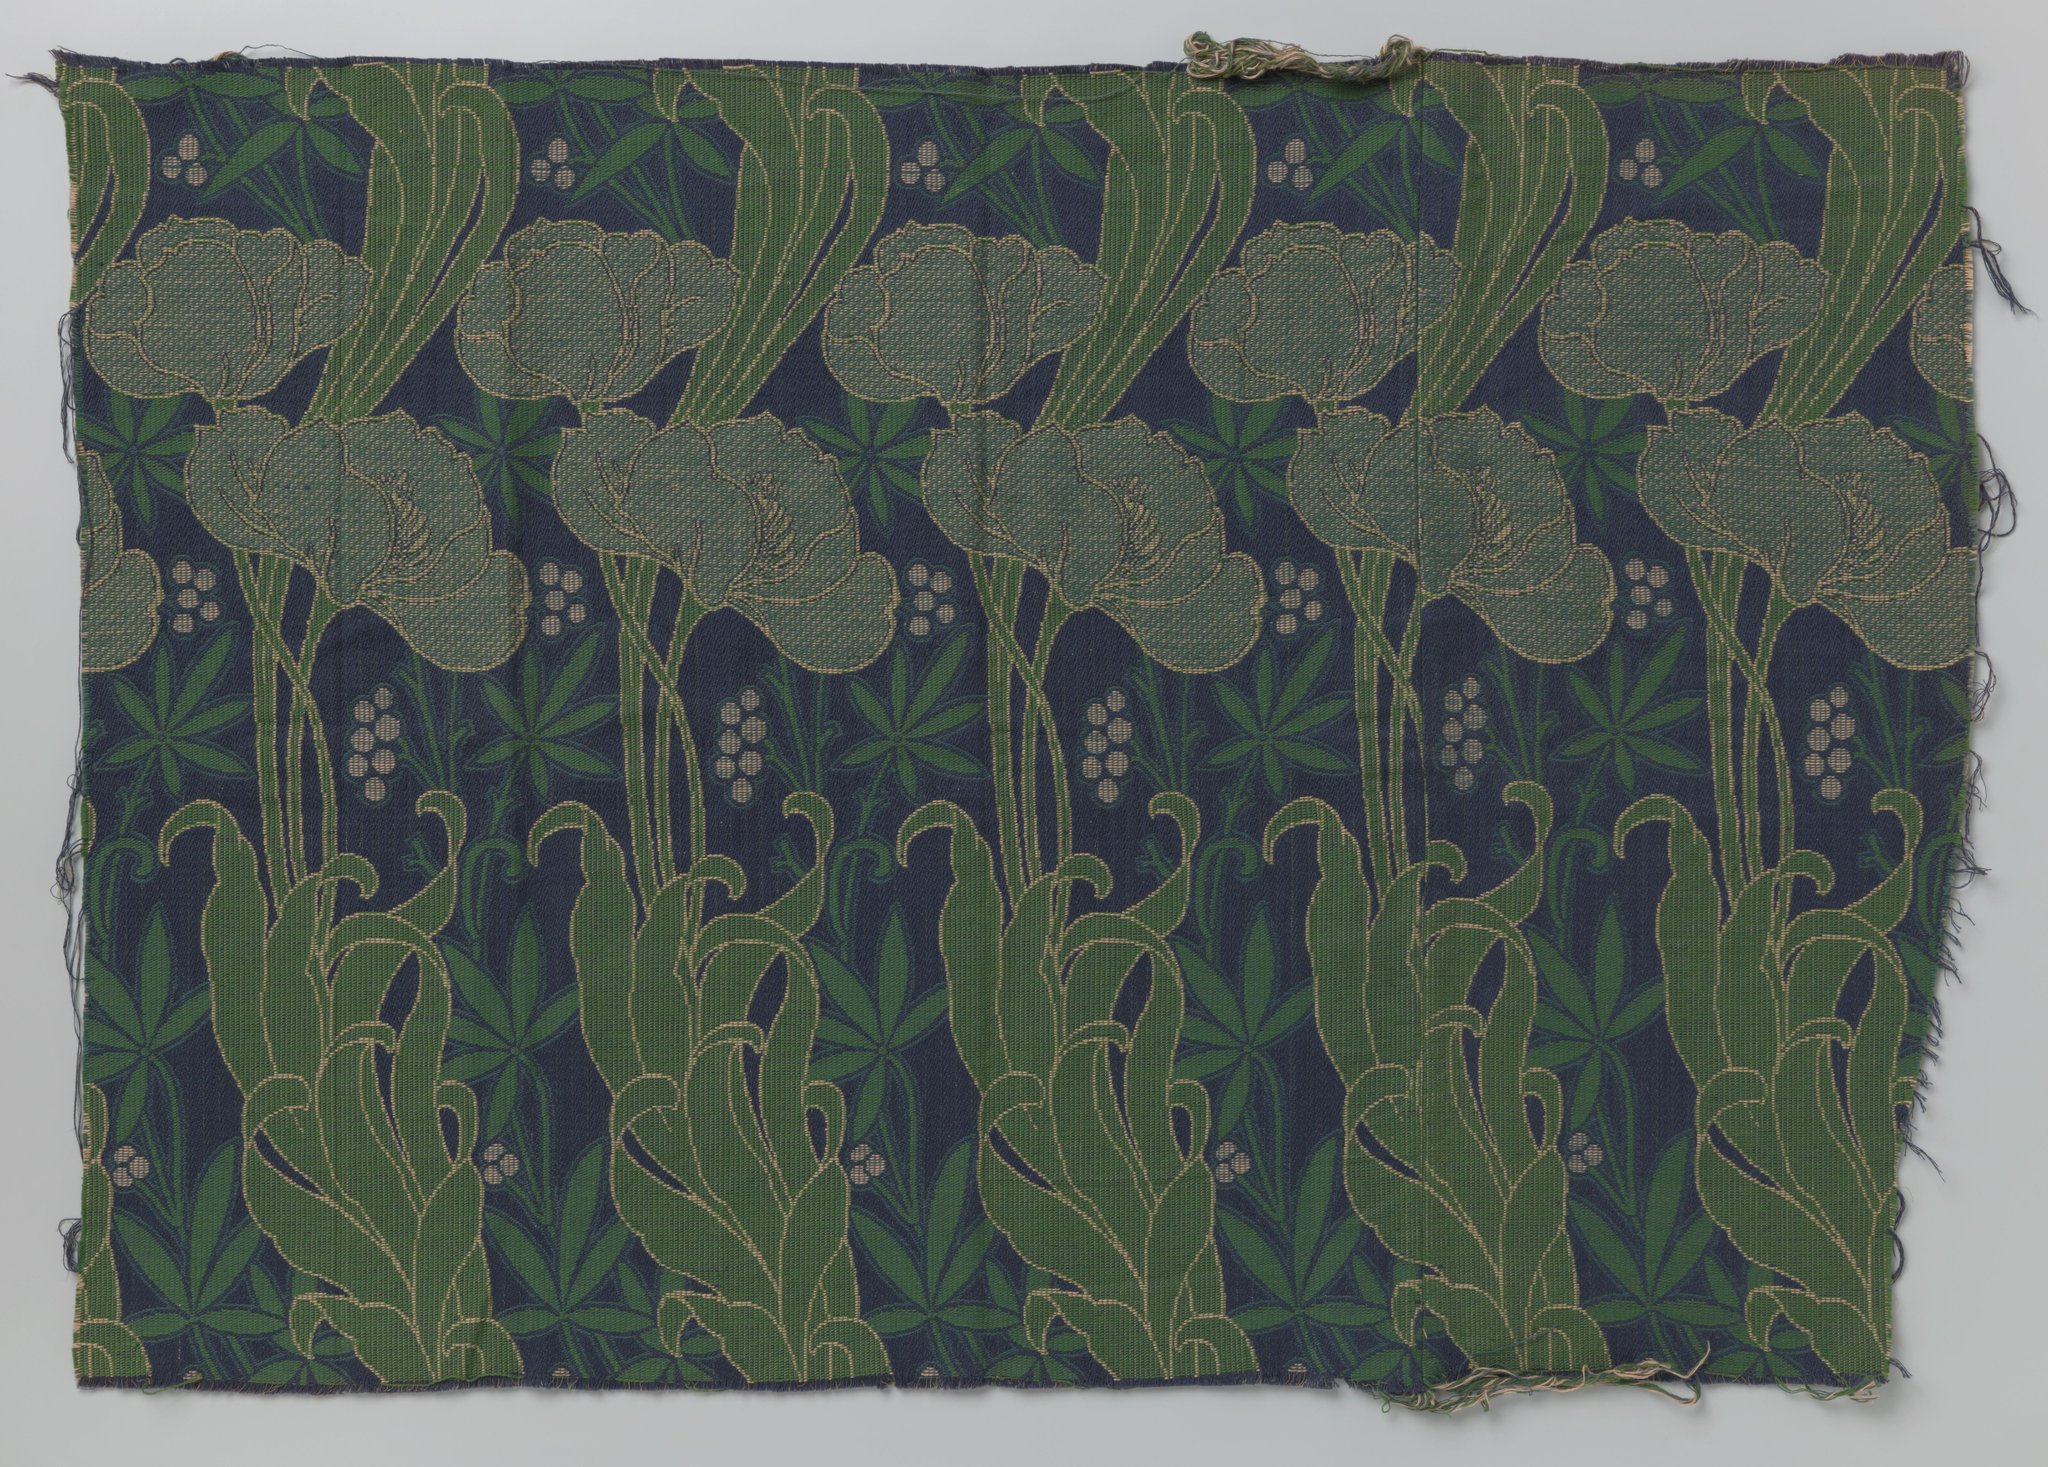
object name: upholstered wall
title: Baan bespanningsstof met Jugendstilpatroon van grote bloemen en bladeren die licht golvende banen vormen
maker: Anonymous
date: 1900-1920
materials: cotton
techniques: weave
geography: england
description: Baan bespanningsstof met Jugendstilpatroon van grote bloemen en bladeren die licht golvende banen vormen.